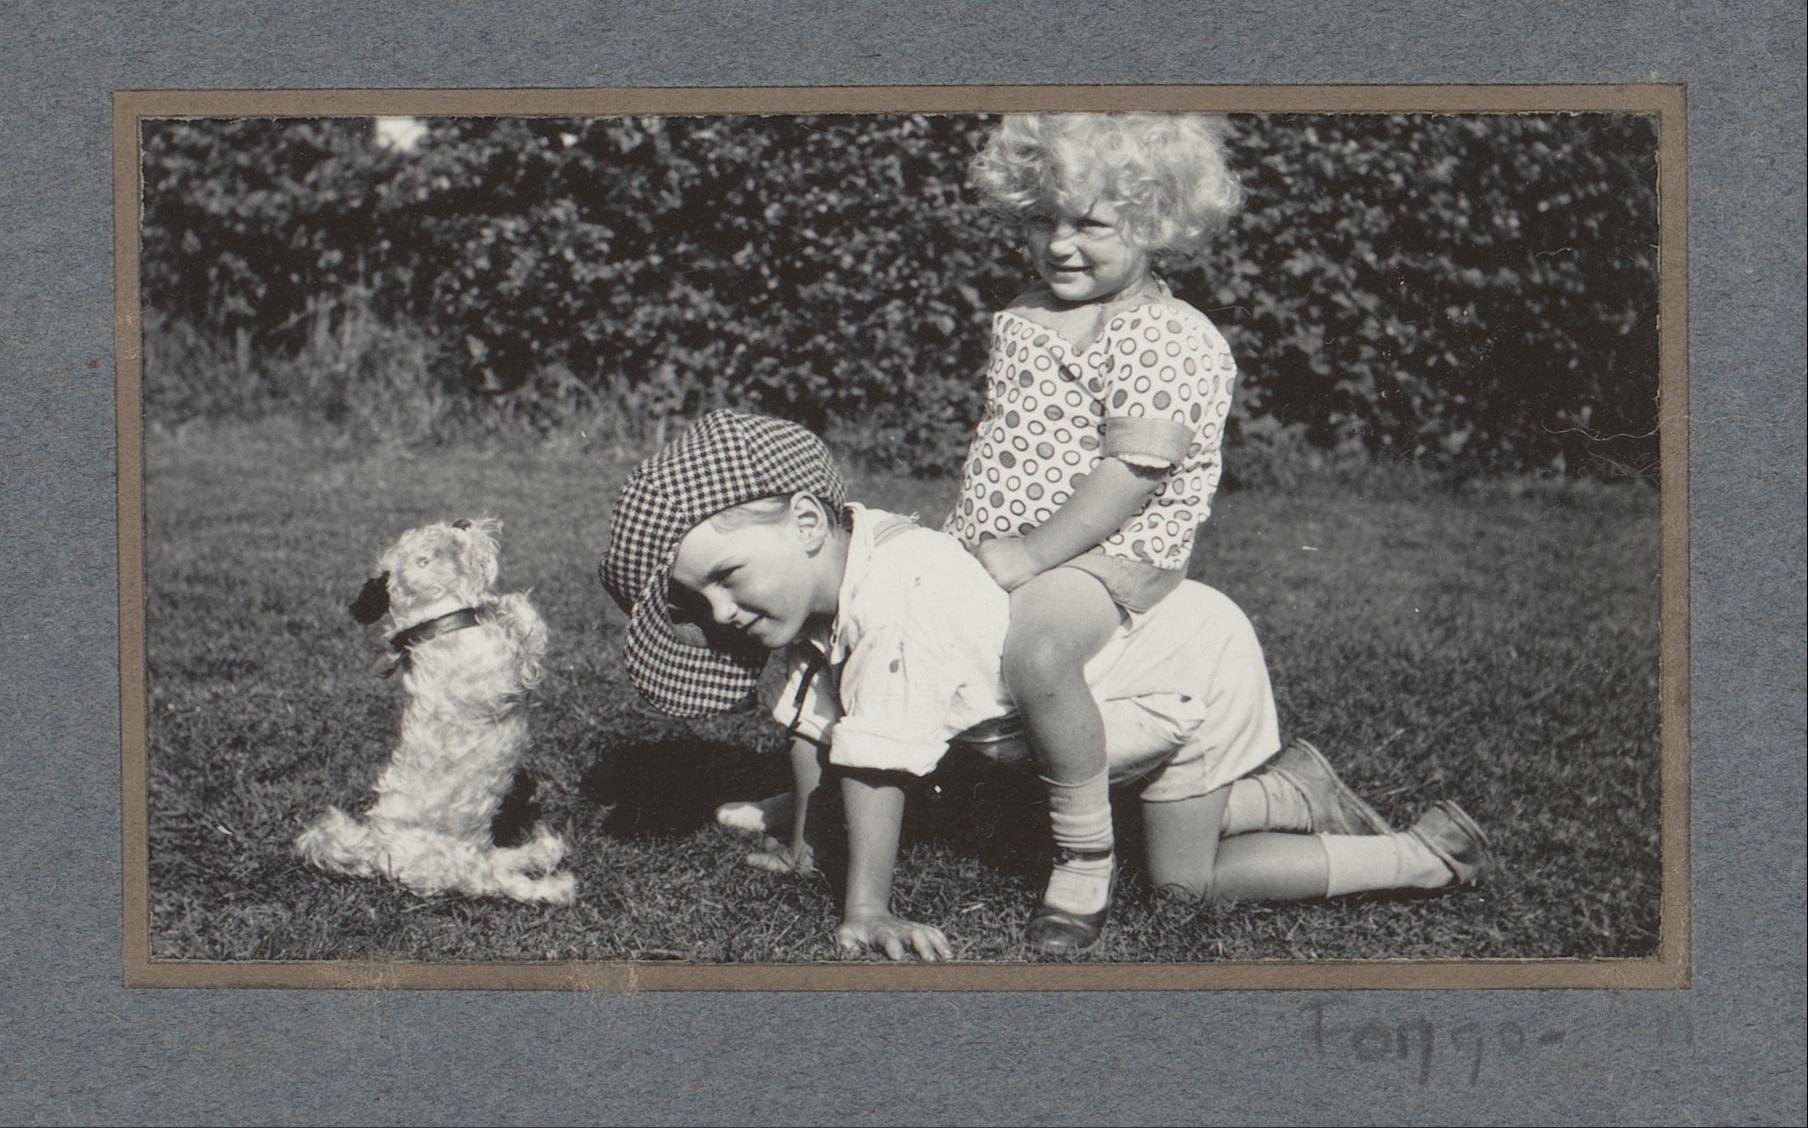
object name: photograph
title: Twee spelende kinderen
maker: Anonymous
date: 1923-1933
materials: photographic support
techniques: gelatin silver print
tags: children's games and plays, child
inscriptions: inscription: ‘Opnamen gemaakt met de Autografische "Kodak" Special No. 2c./ Afdrukken gemaakt op "Velox" papier.’